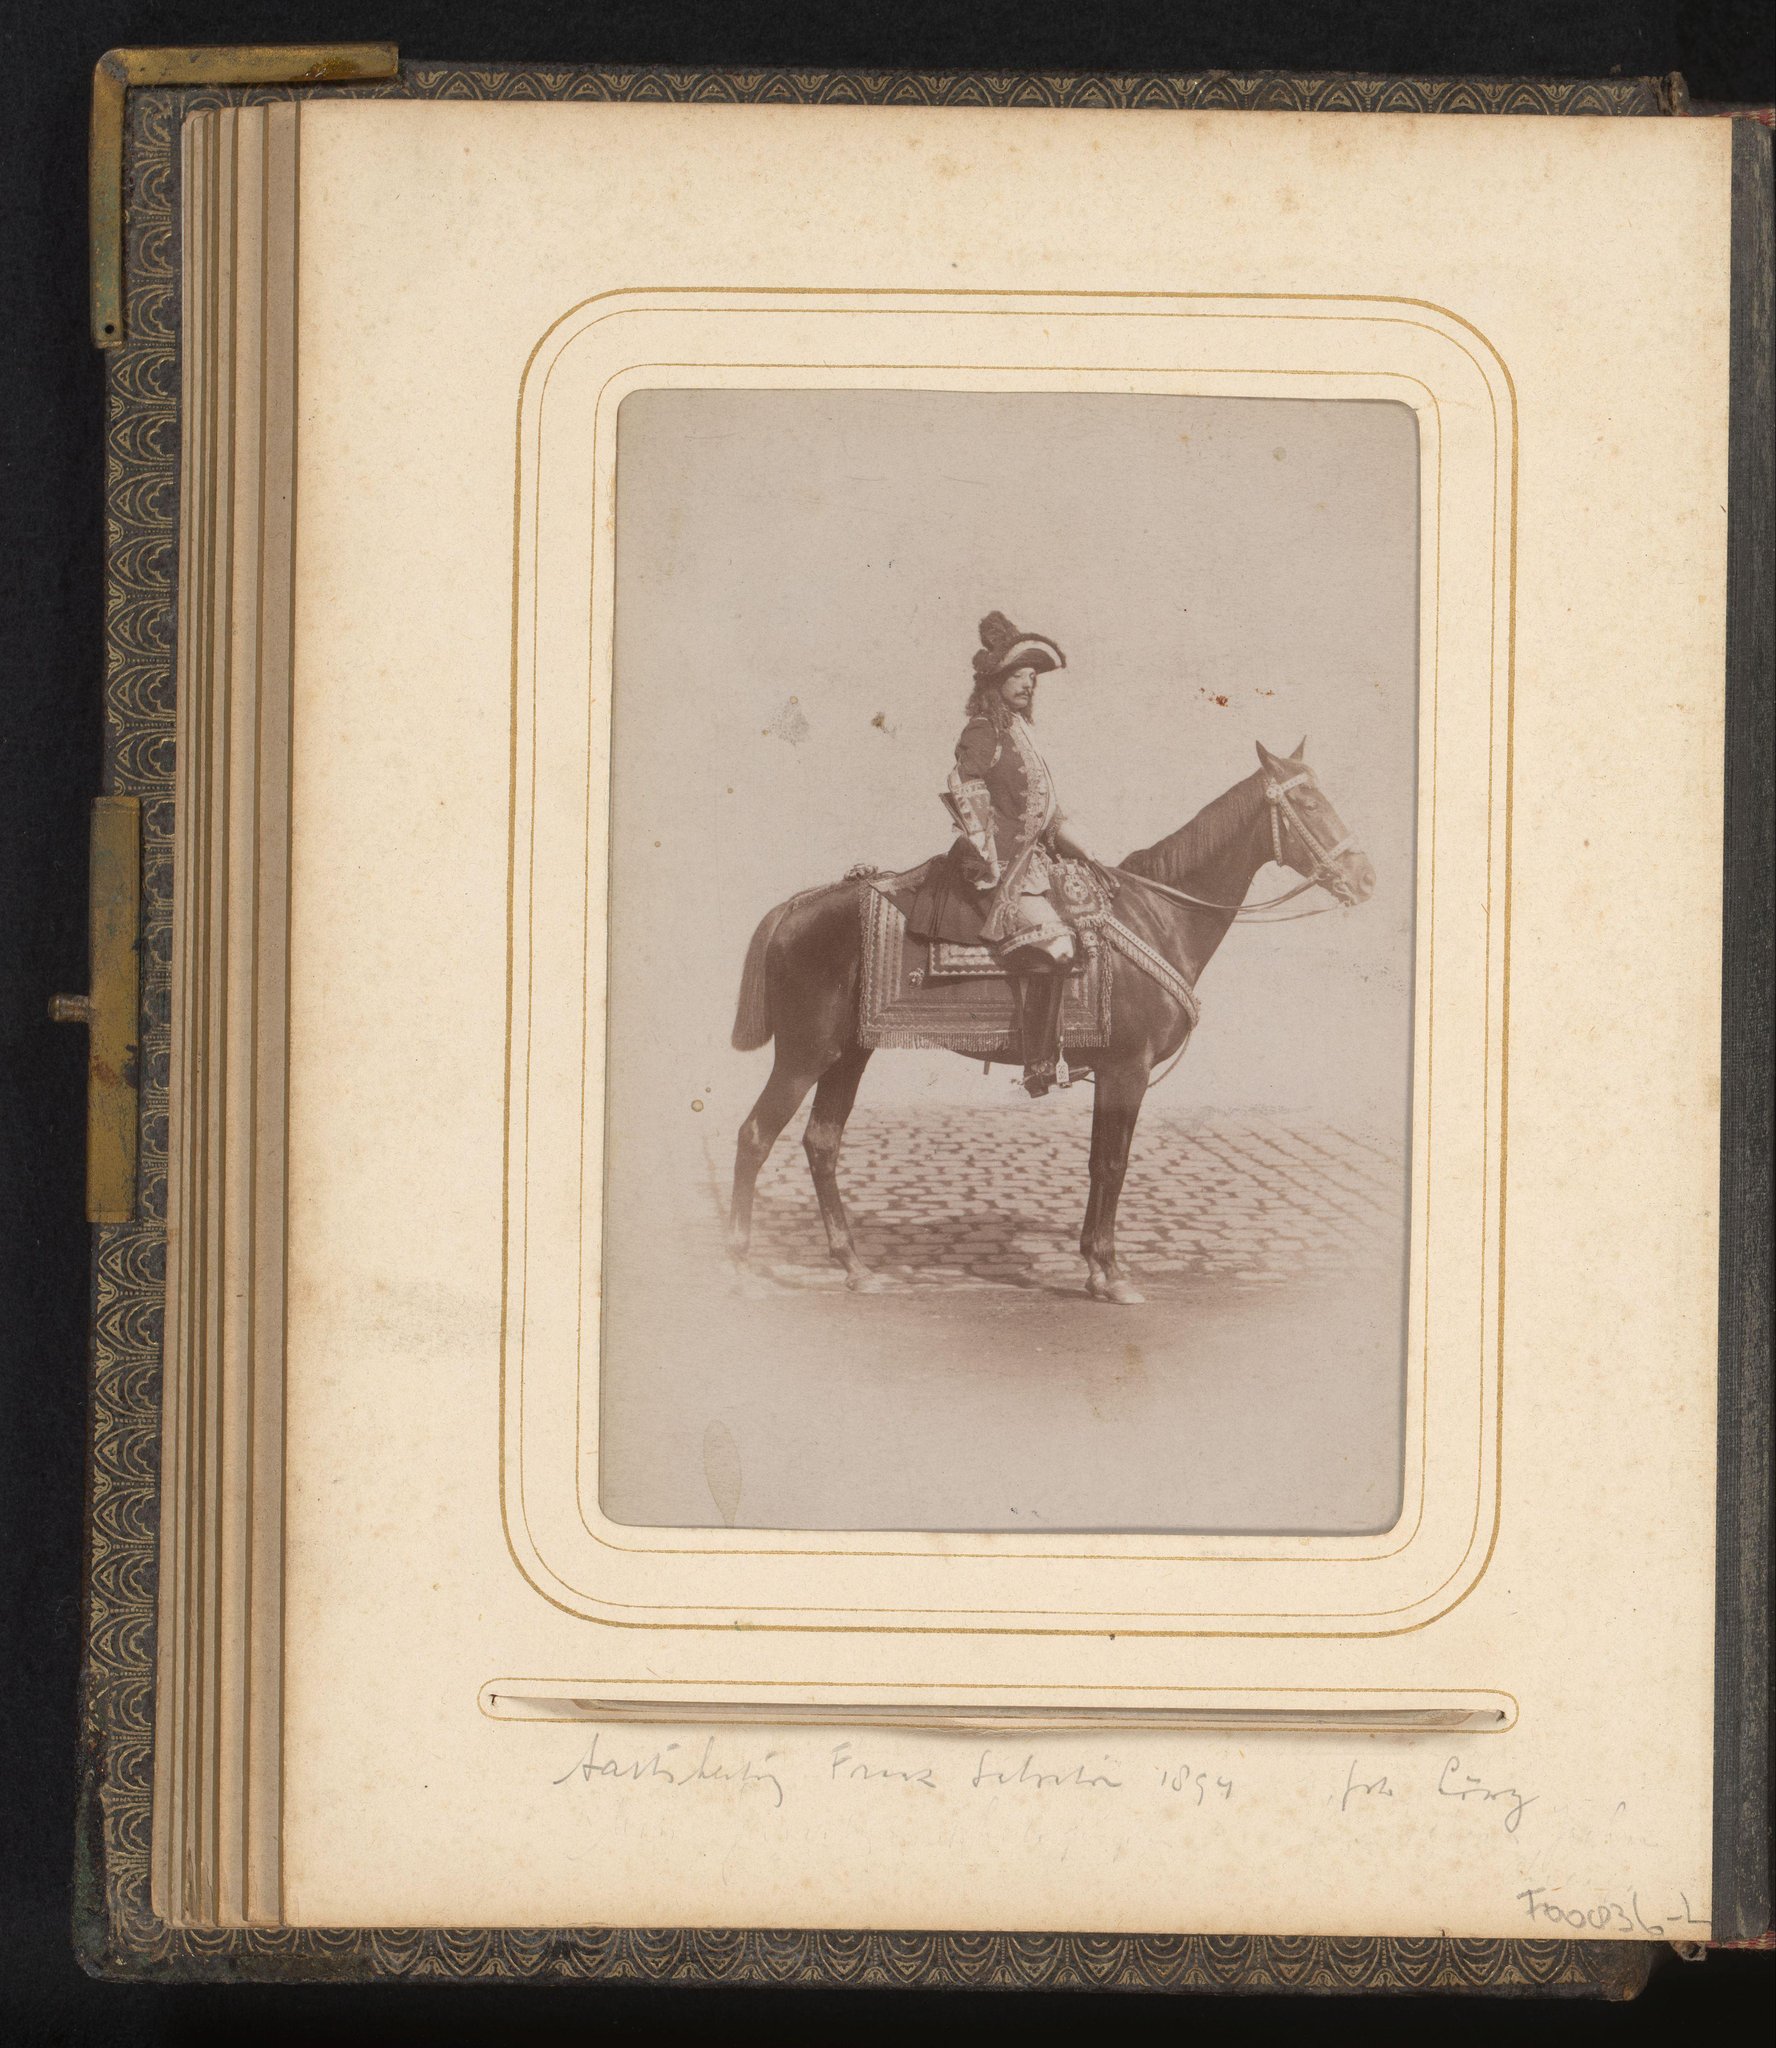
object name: photograph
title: Portret van aartshertog Franz Salvator te paard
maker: josef löwy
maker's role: publisher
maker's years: 1835-1902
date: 1894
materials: cardboard, photographic support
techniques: collodion silver print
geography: vienna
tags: vienna, historical persons, ruler, sovereign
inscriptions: annotation: ‘Erzh. Franz Salvator’, annotation: ‘Erzh. Franz Salvator’, inscription: ‘Das carroussel zu Wien, 1894’, annotation: ‘Aartshertog Franz Salvator 1894/ foto Löwy’